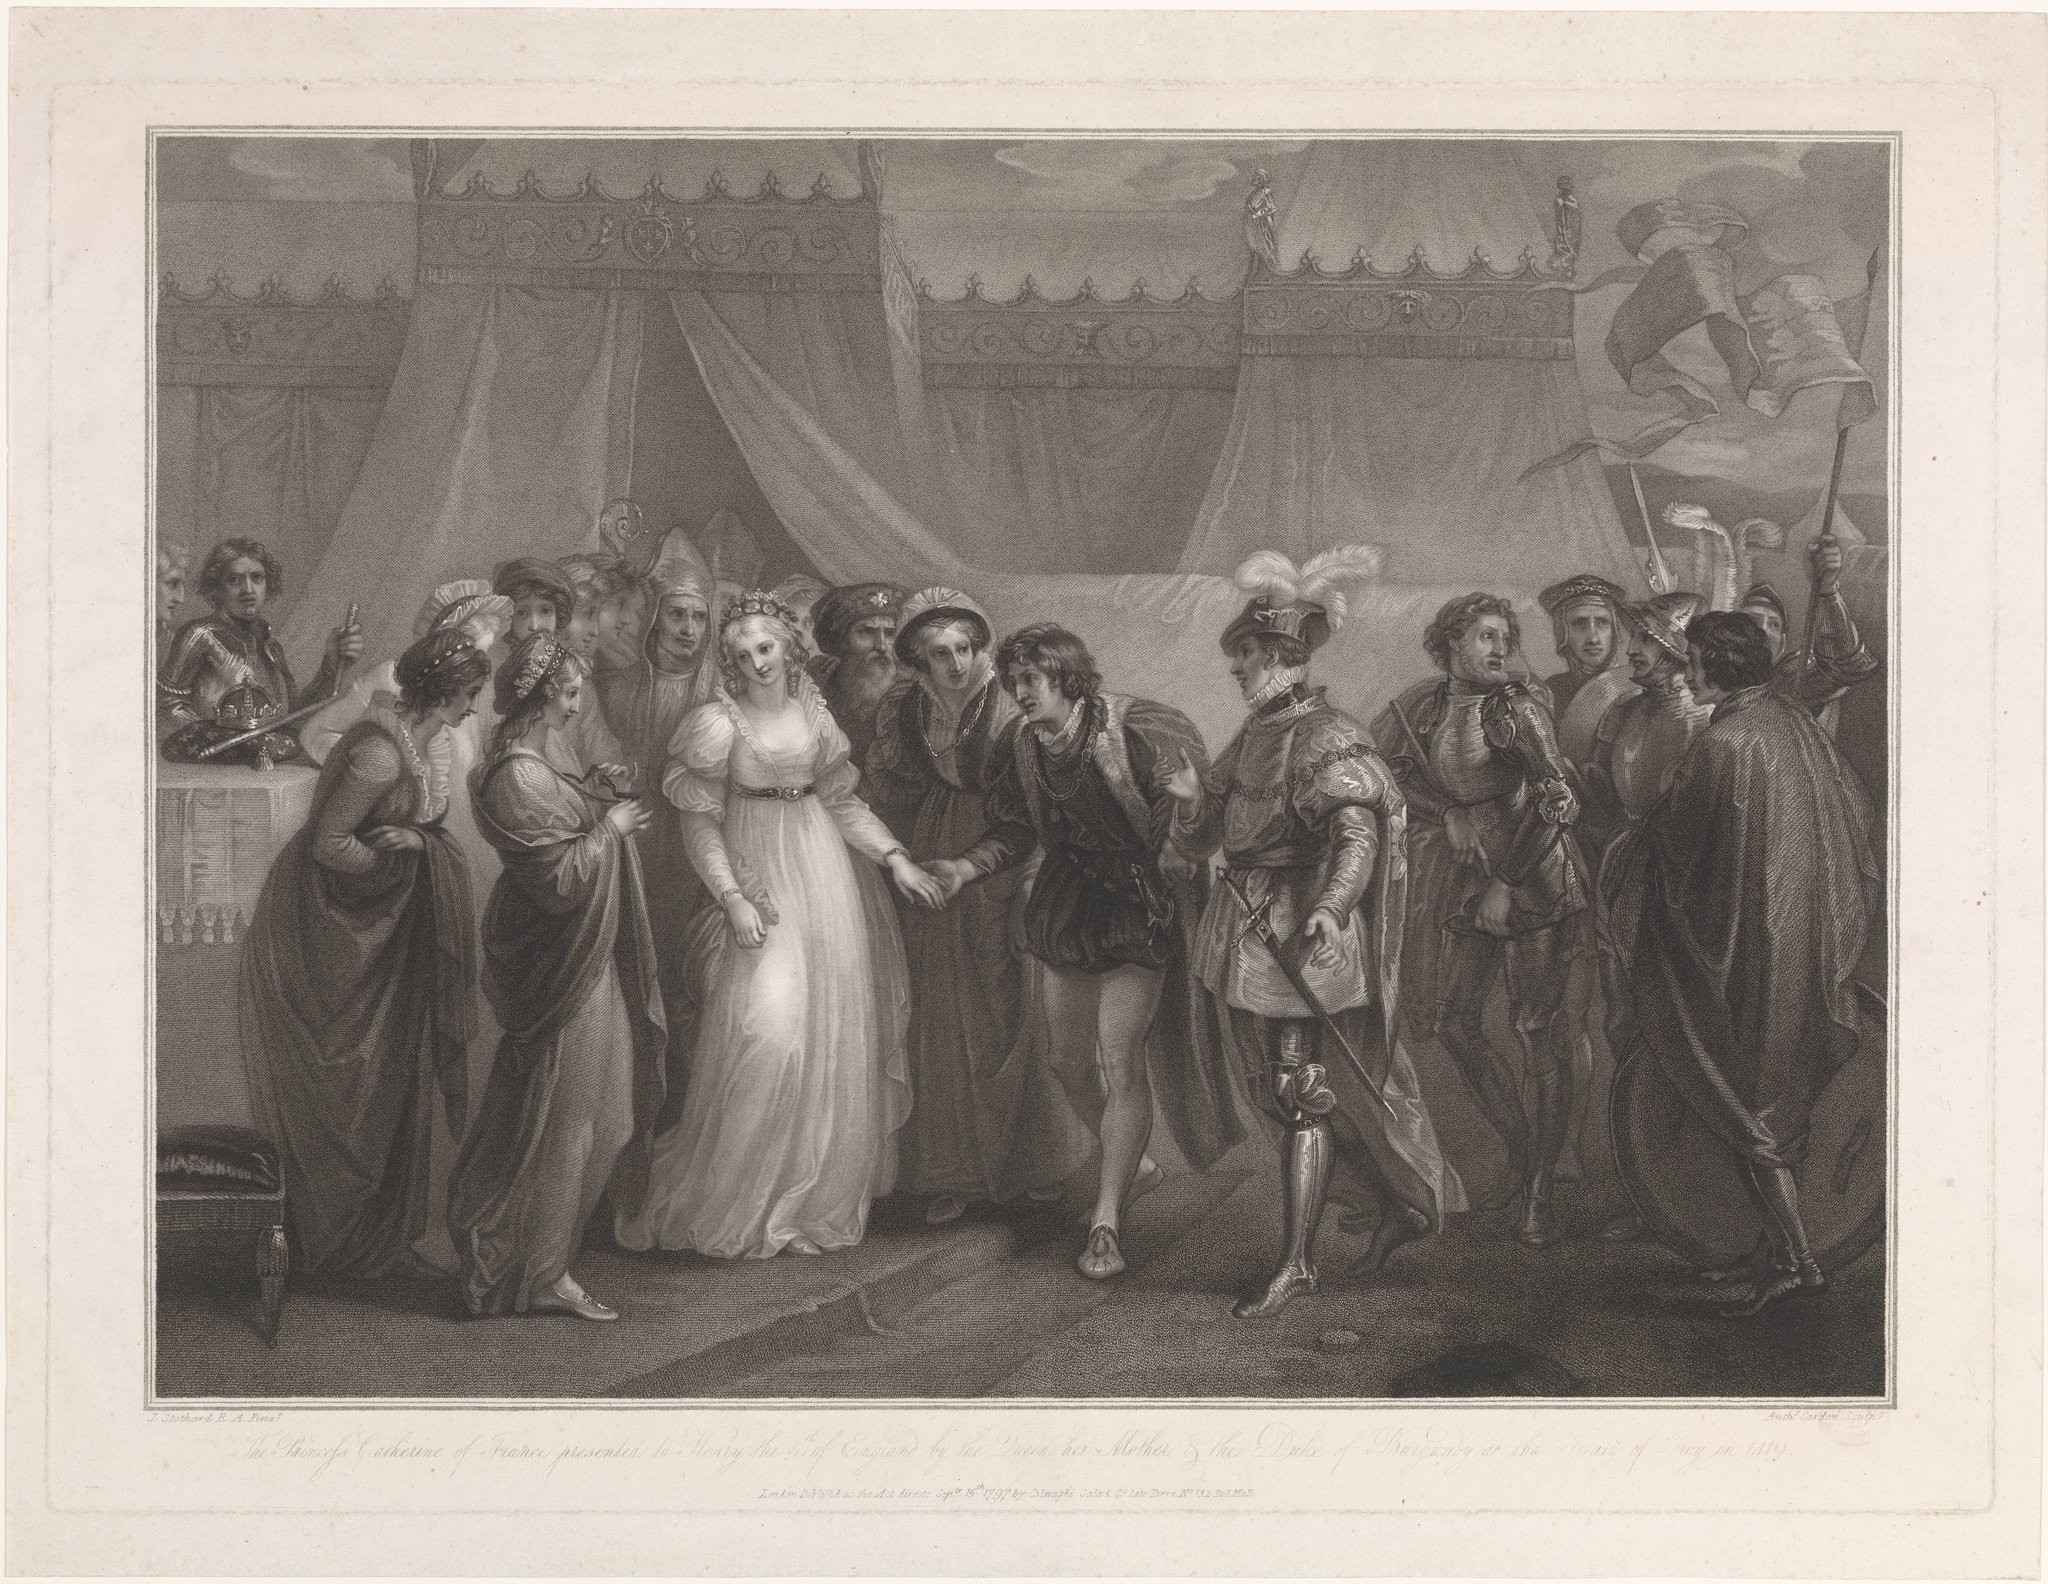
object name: print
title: The princess Catherine of France presented to Henry the 5th of England (...)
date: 1797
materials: paper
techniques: stippled etching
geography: london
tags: (civil) marriage ceremonies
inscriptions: collector's mark: Lugt 12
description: Catherine van Valois wordt aan haar toekomstige echtgenoot koning Hendrik V van Engeland geintroduceerd.